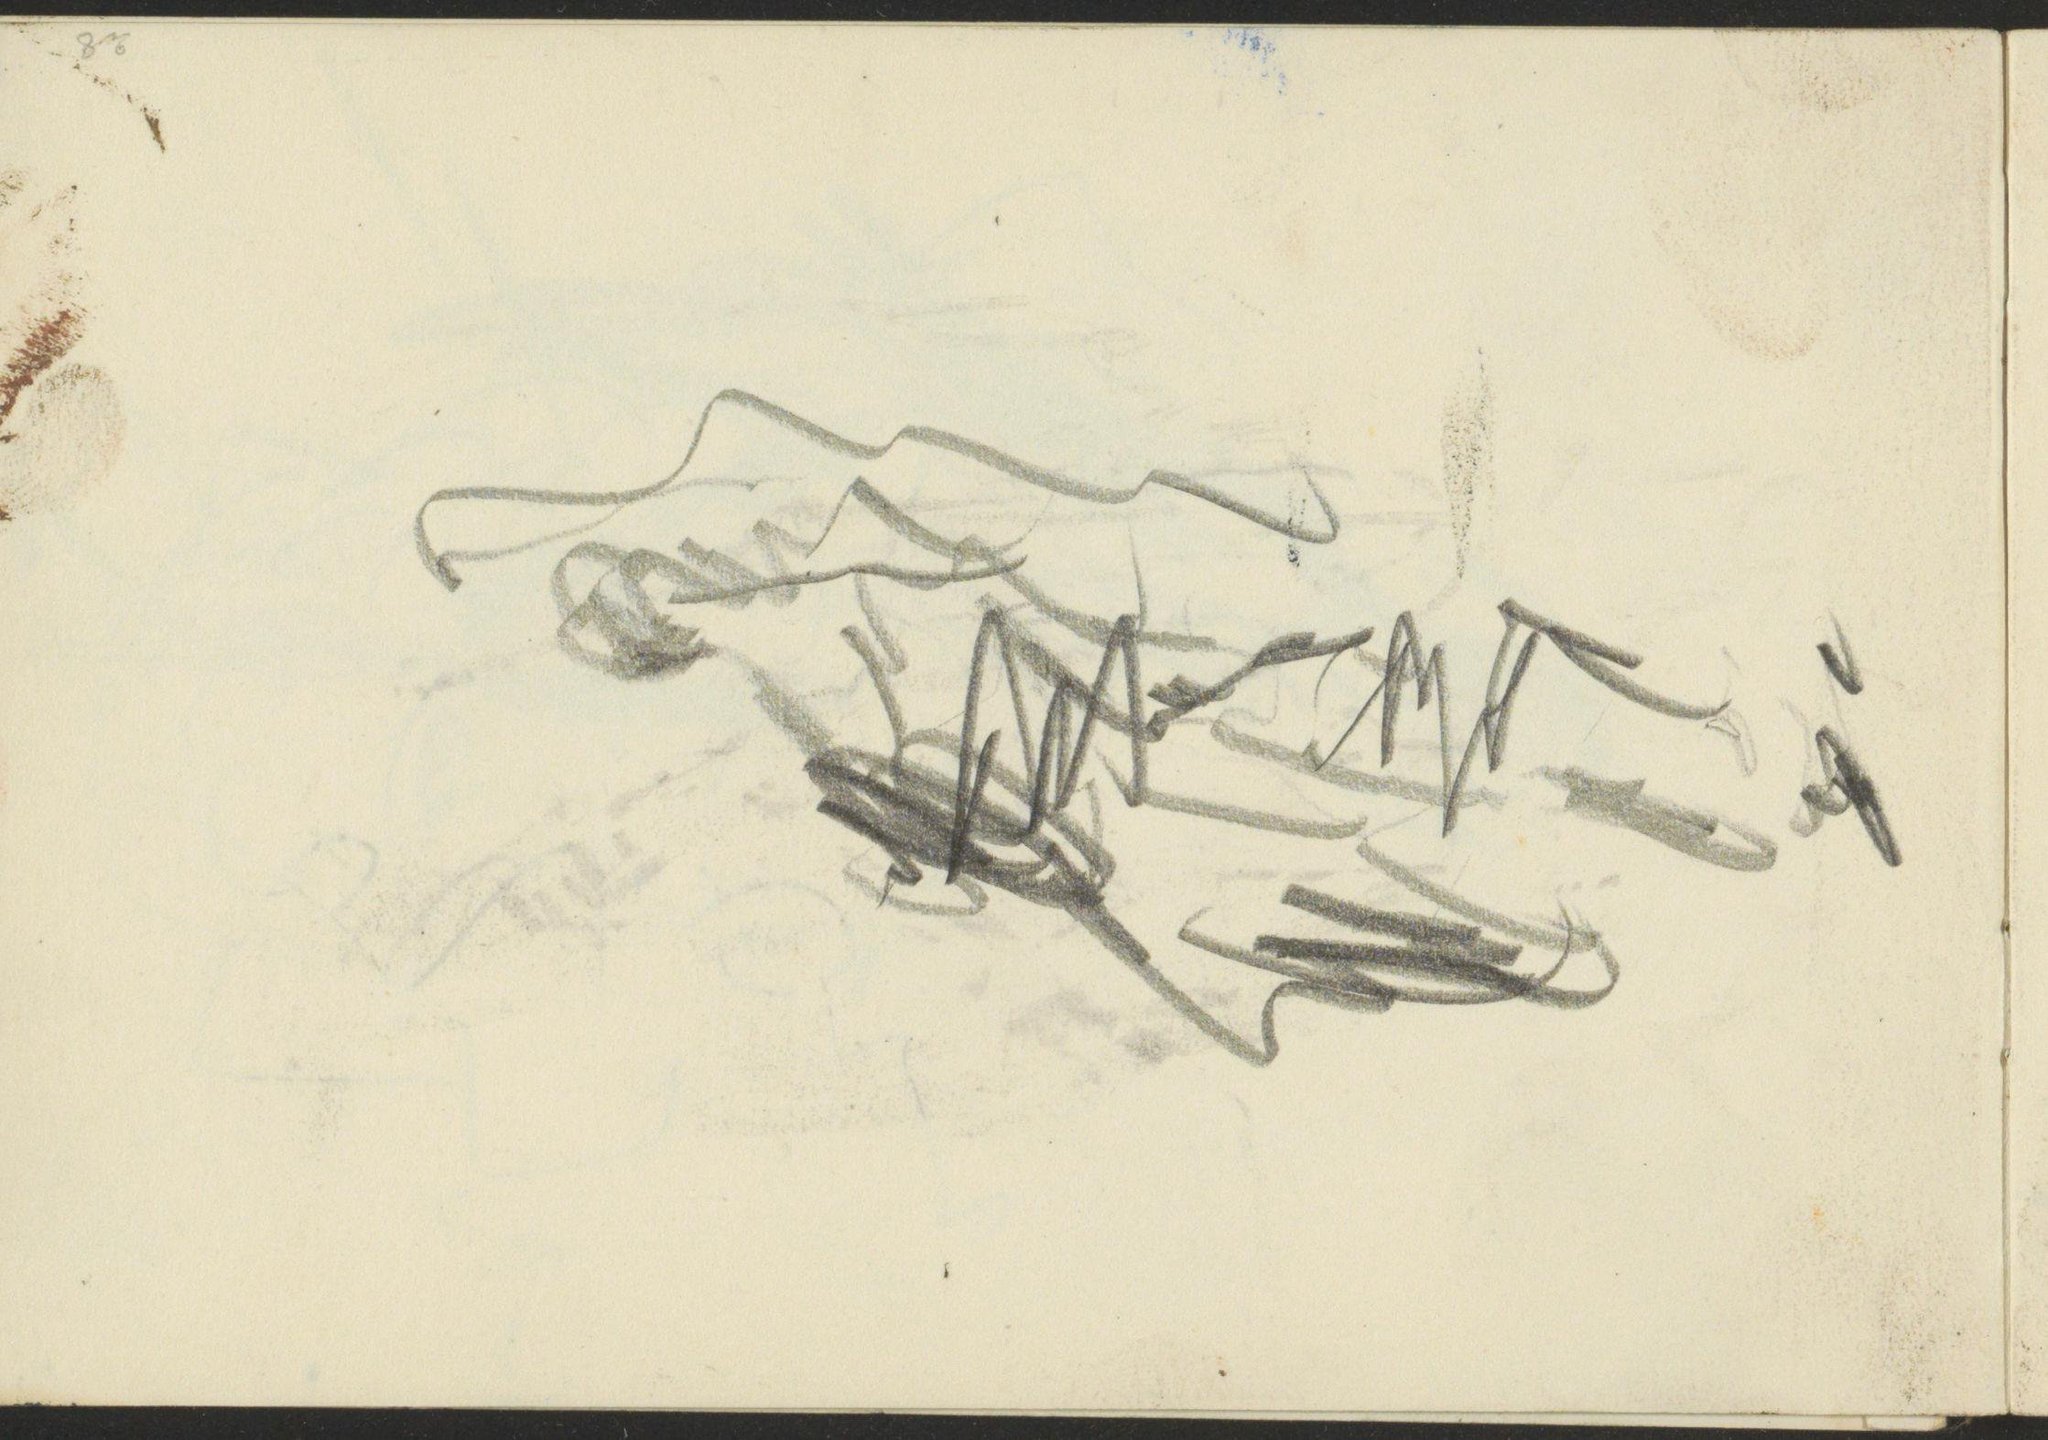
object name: sketchbook leaf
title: Staande man in jacquet, in profiel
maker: isaac israels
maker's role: draughtsman, painter, print maker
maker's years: 1865-1934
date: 1875-1934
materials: paper, pencil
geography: the hague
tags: adult man (+ standing)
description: Hij buigt licht voorover. Blad 13 verso uit schetsboek LXI met 20 bladen.